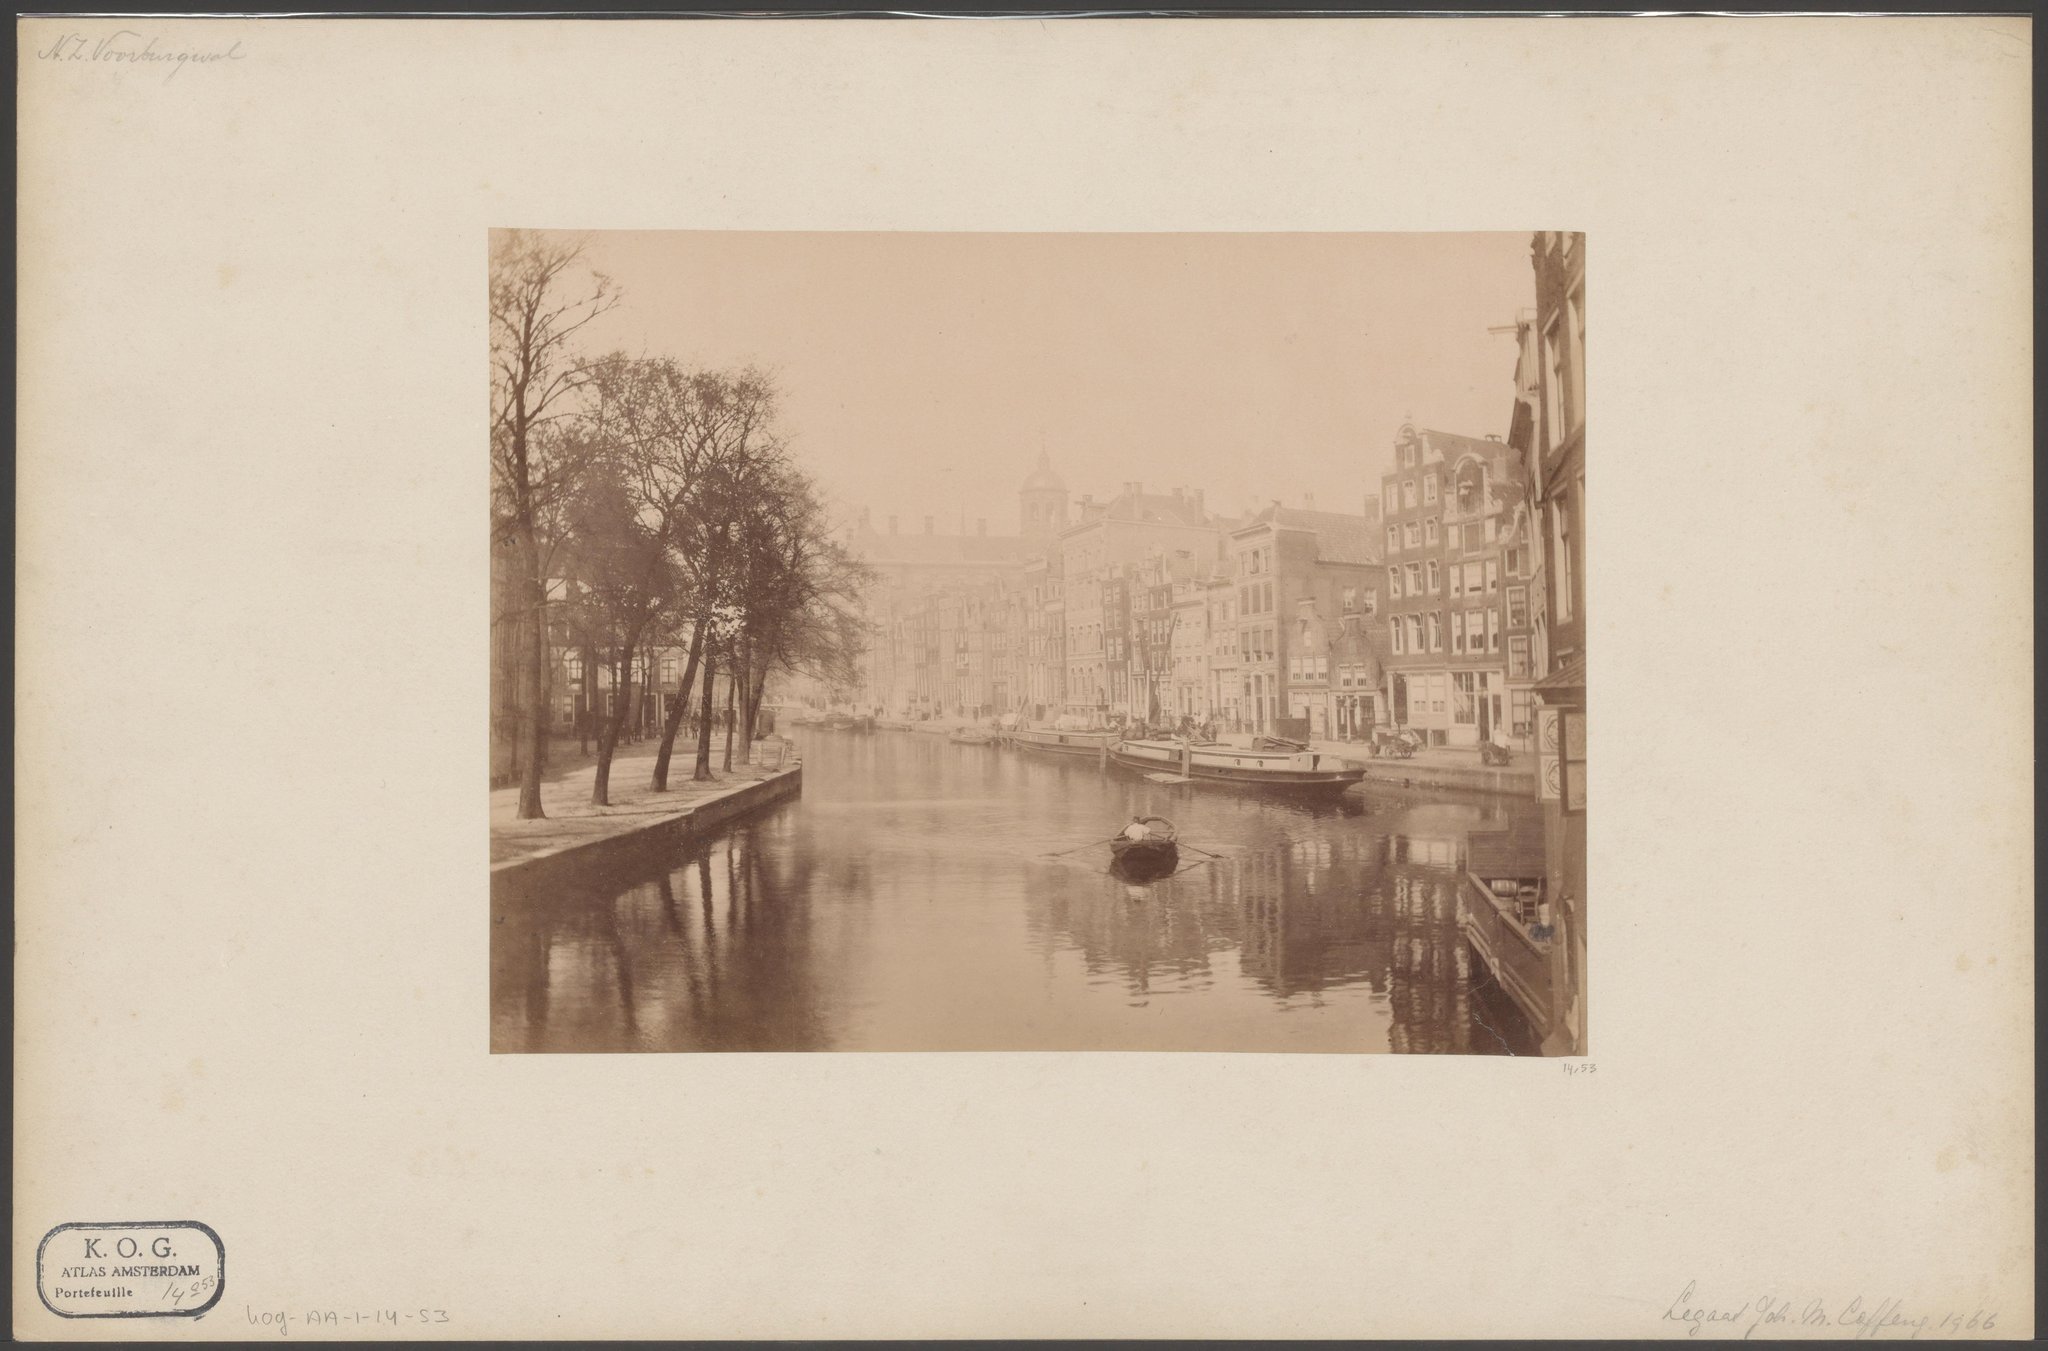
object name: photograph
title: Gezicht op de Nieuwezijds Voorburgwal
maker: Anonymous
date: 1850-1884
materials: cardboard, paper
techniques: albumen print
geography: amsterdam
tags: city-view in general; 'veduta', canal, the usual house or row of houses, bridge in city across river, canal, etc., street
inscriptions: collector's mark: ‘14a53’ Lugt 1641b, inscription: ‘Legaat Joh. M. Coffeng. 1966’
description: Onderwerpsrubriek binnen de Atlas Amsterdam: Verhulststraat (Johannes), Viaducten, Vierwindenstraat, Vinkenbuurt, Vinkenpad, Vinkenstraat, Vischsteeg, Vliegendesteeg, Voetboogstraat, Volewijk, Vondelstraat, Voorburgwal (N.Z.).